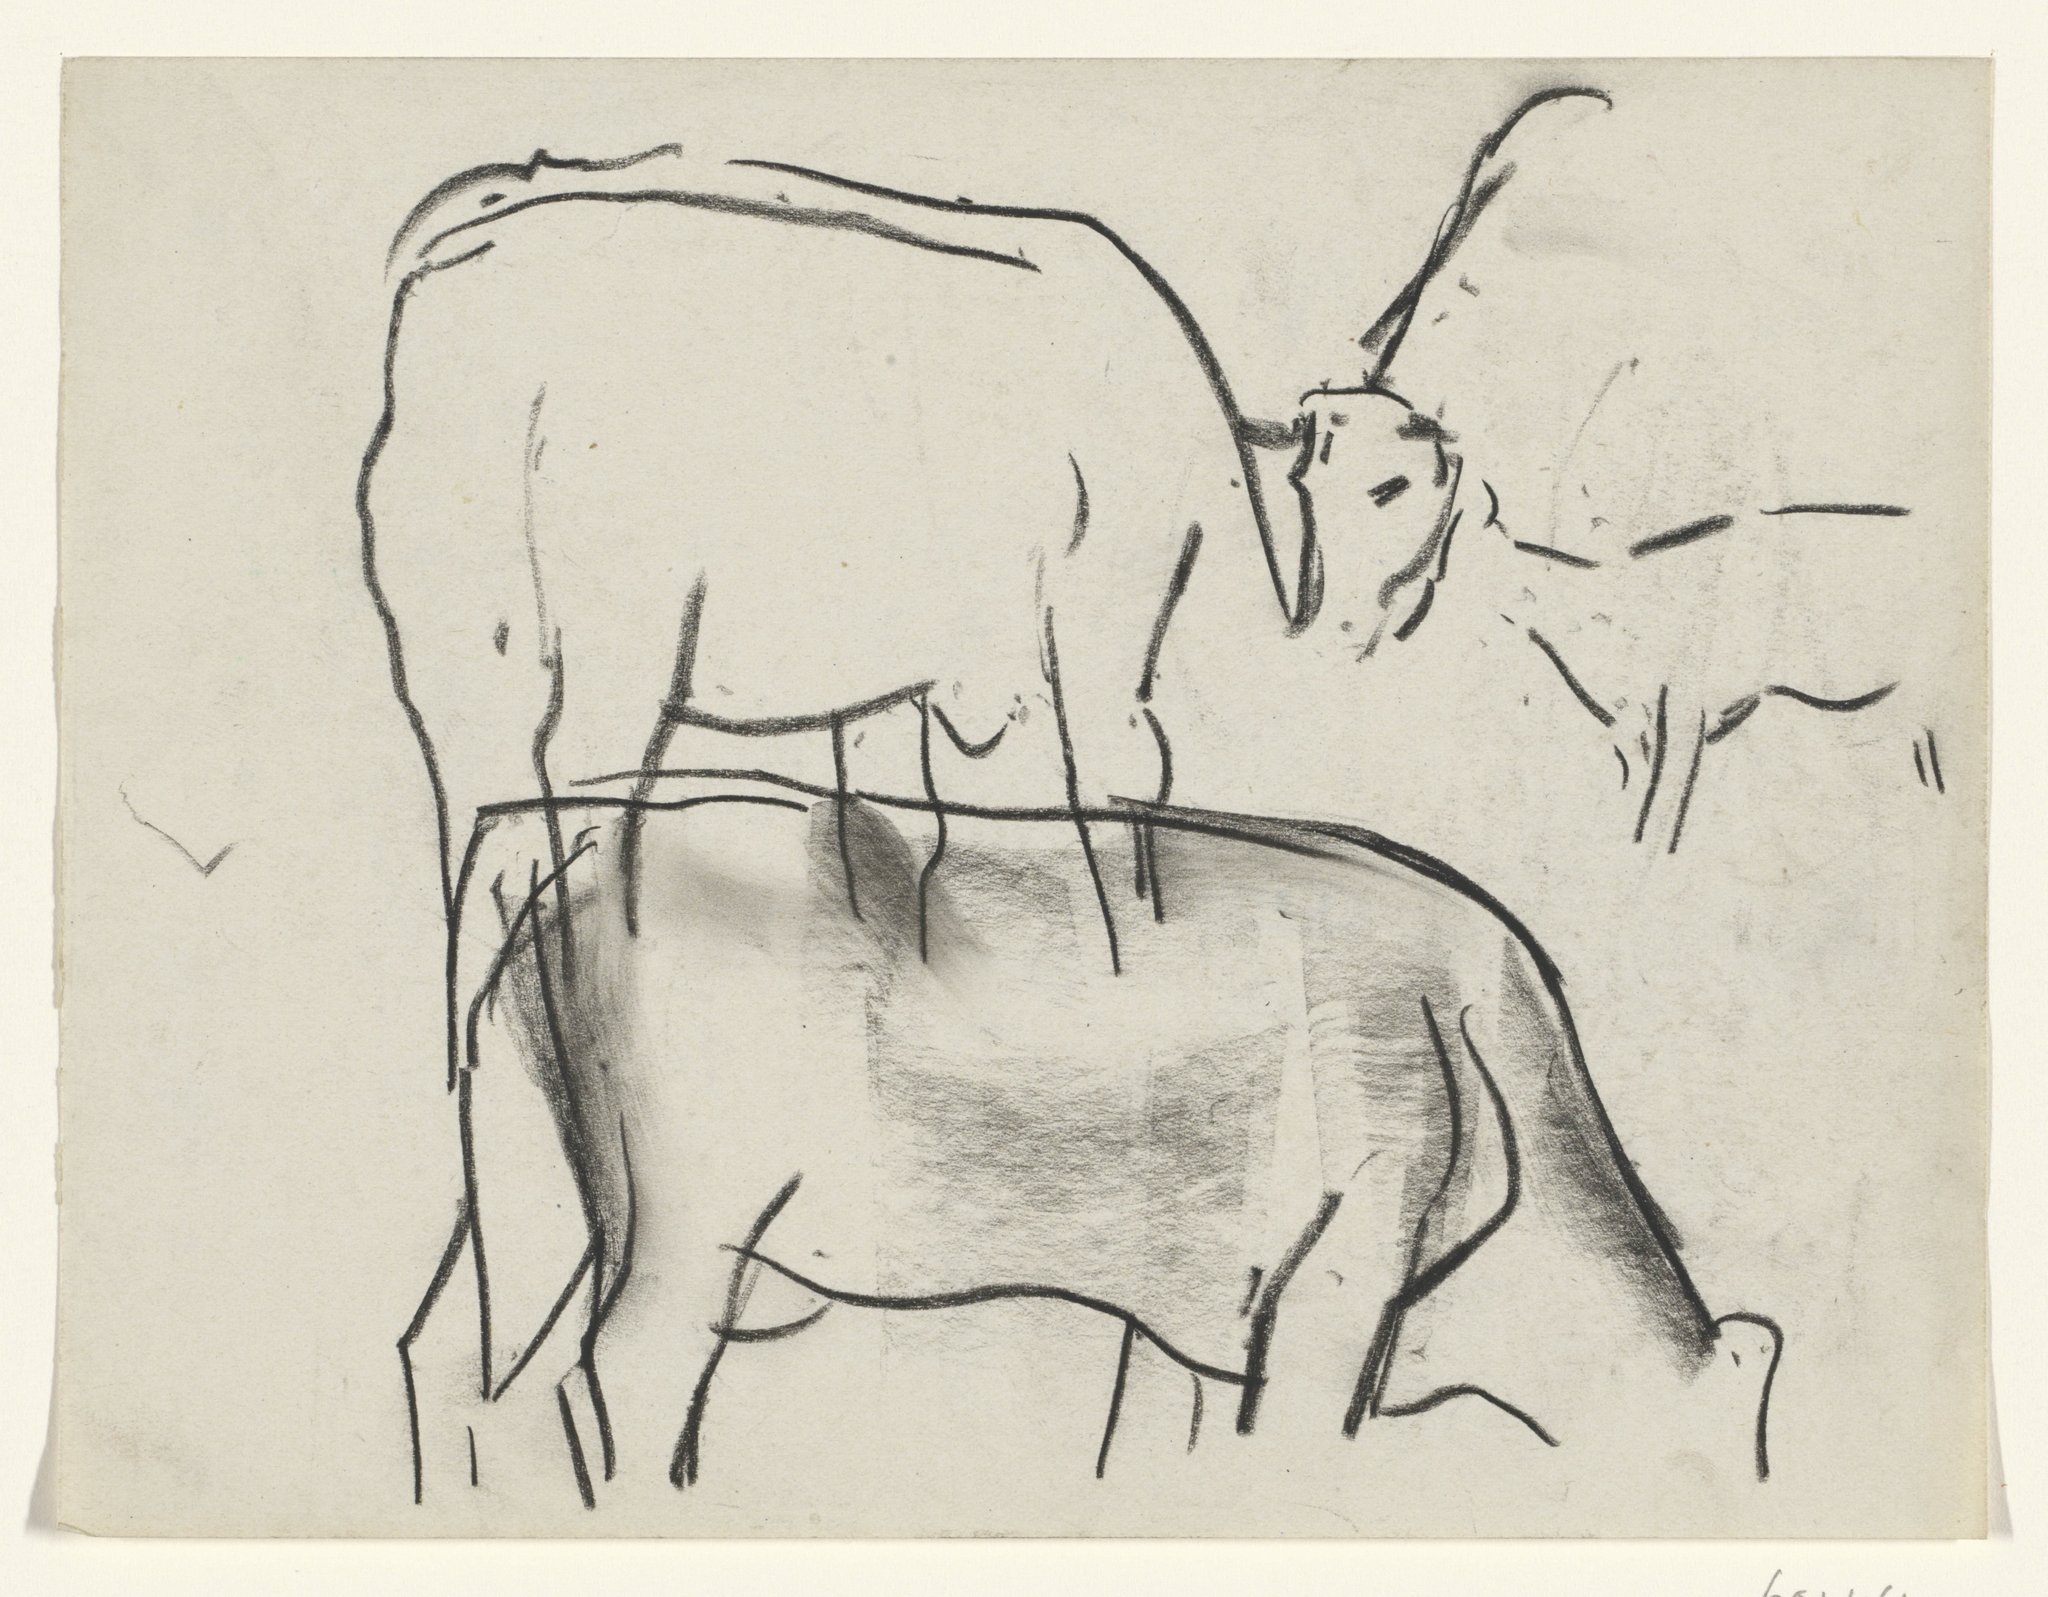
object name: drawing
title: Koeien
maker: leo gestel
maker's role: draughtsman, print maker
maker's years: 1881-1941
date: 1891-1941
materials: chalk, paper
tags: cow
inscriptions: collector's mark: Lugt 2228